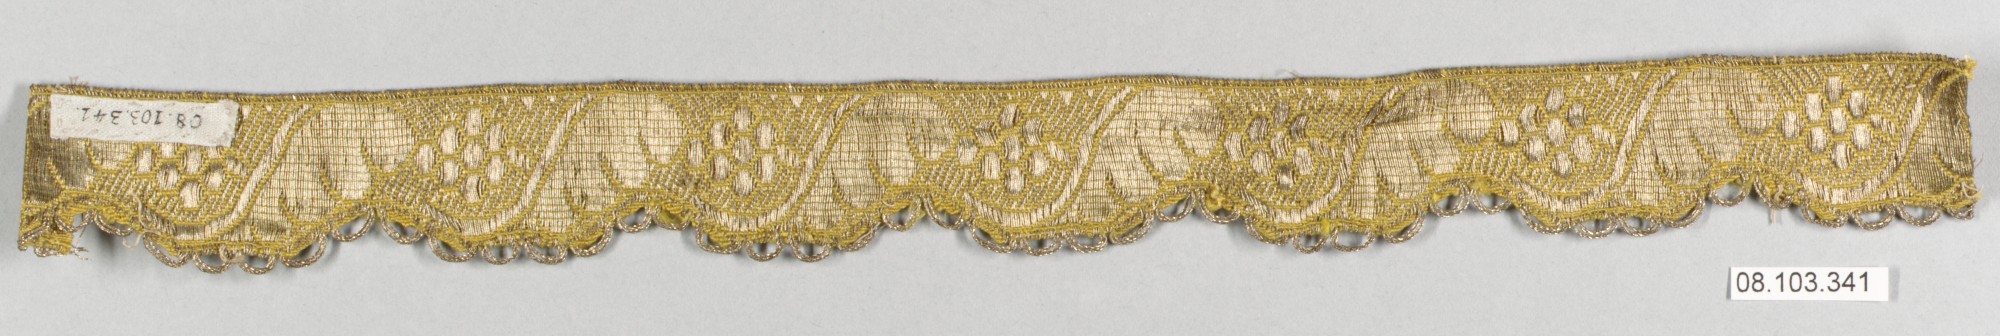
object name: galloon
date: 1601-1800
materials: metal thread, silk